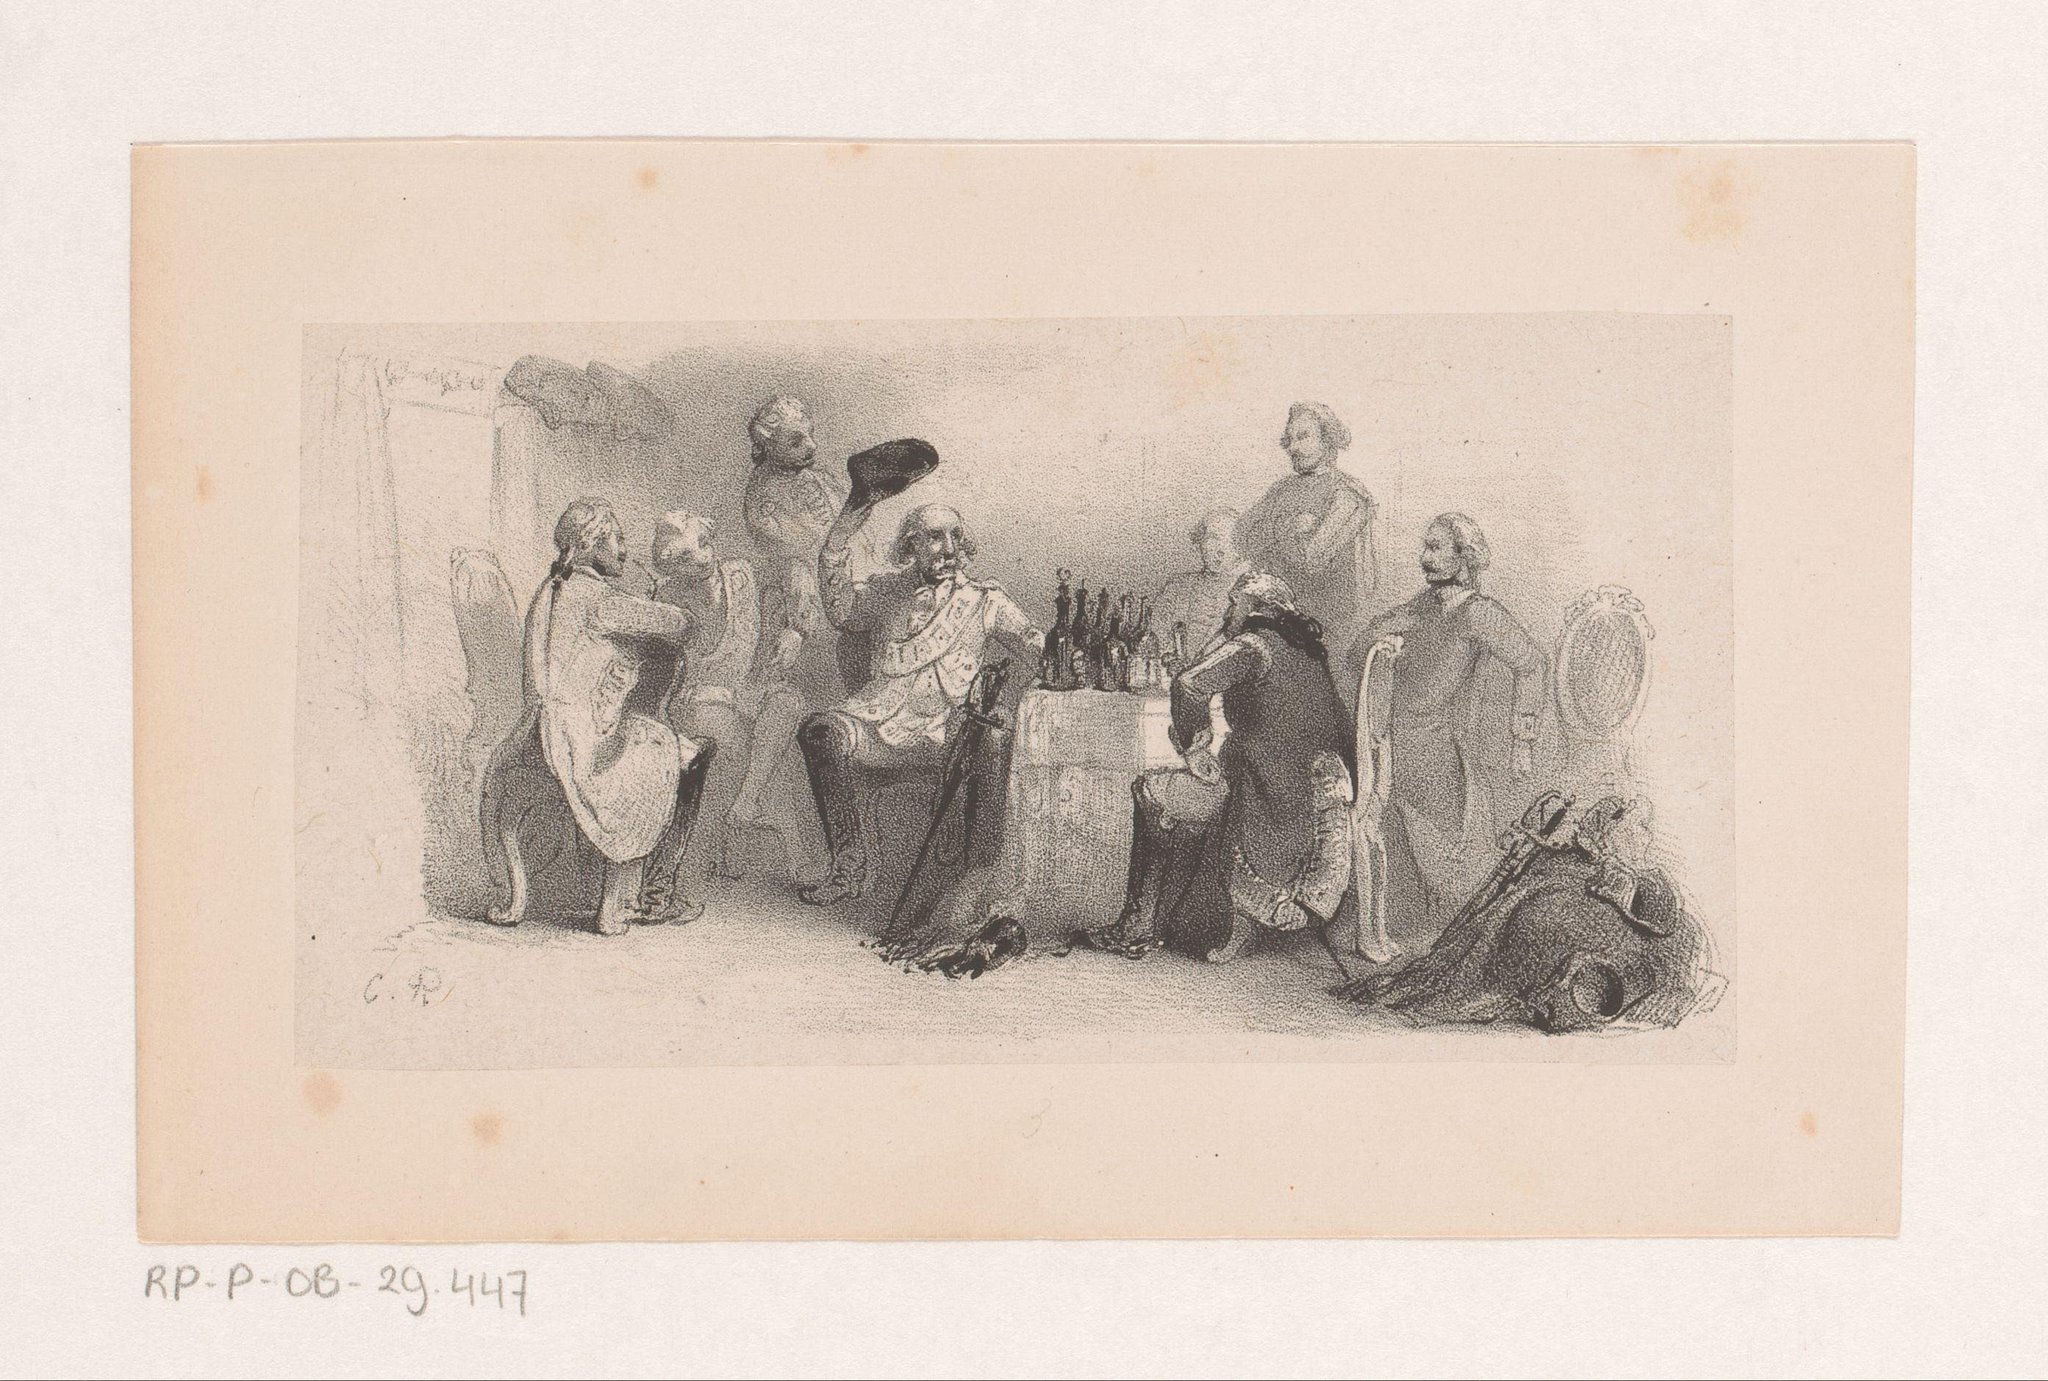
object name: book illustration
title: Groep mannen aan tafel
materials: paper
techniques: lithograph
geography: the hague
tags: baron münchausen, adult man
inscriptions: collector's mark: Lugt 2228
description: In een interieur zit een groep mannen rondom een tafel waarop flessen staan. De man in het midden neemt zijn hoed af. De man rechts op de rug gezien is vermoedelijk Karl Friedrich Hieronymus Baron von Münchhausen.